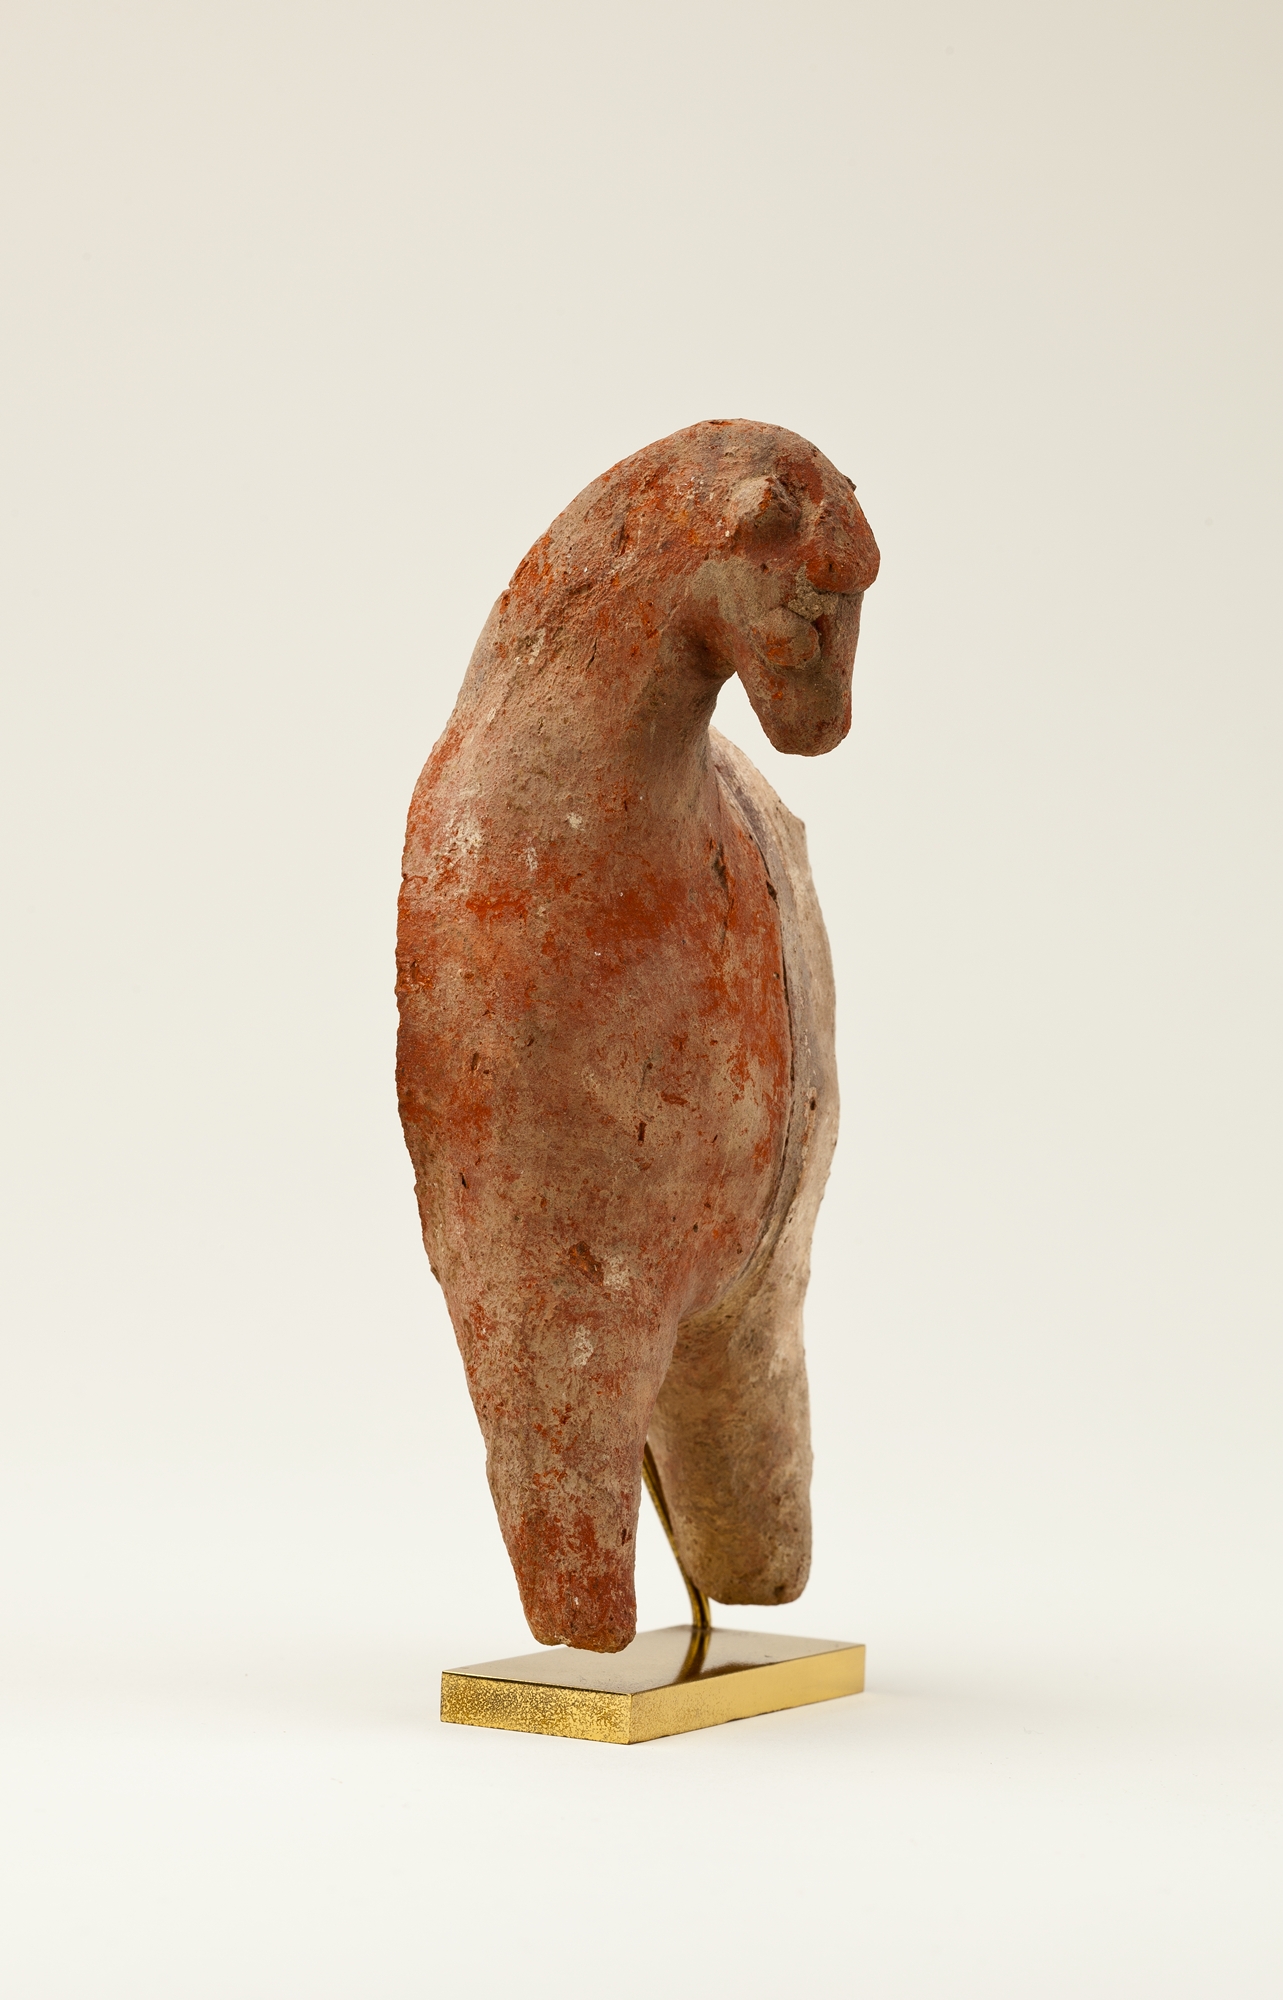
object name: vessel, horse or camel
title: Vessel in the shape of a horse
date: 306-30 BCE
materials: paint, pottery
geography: egypt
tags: animals